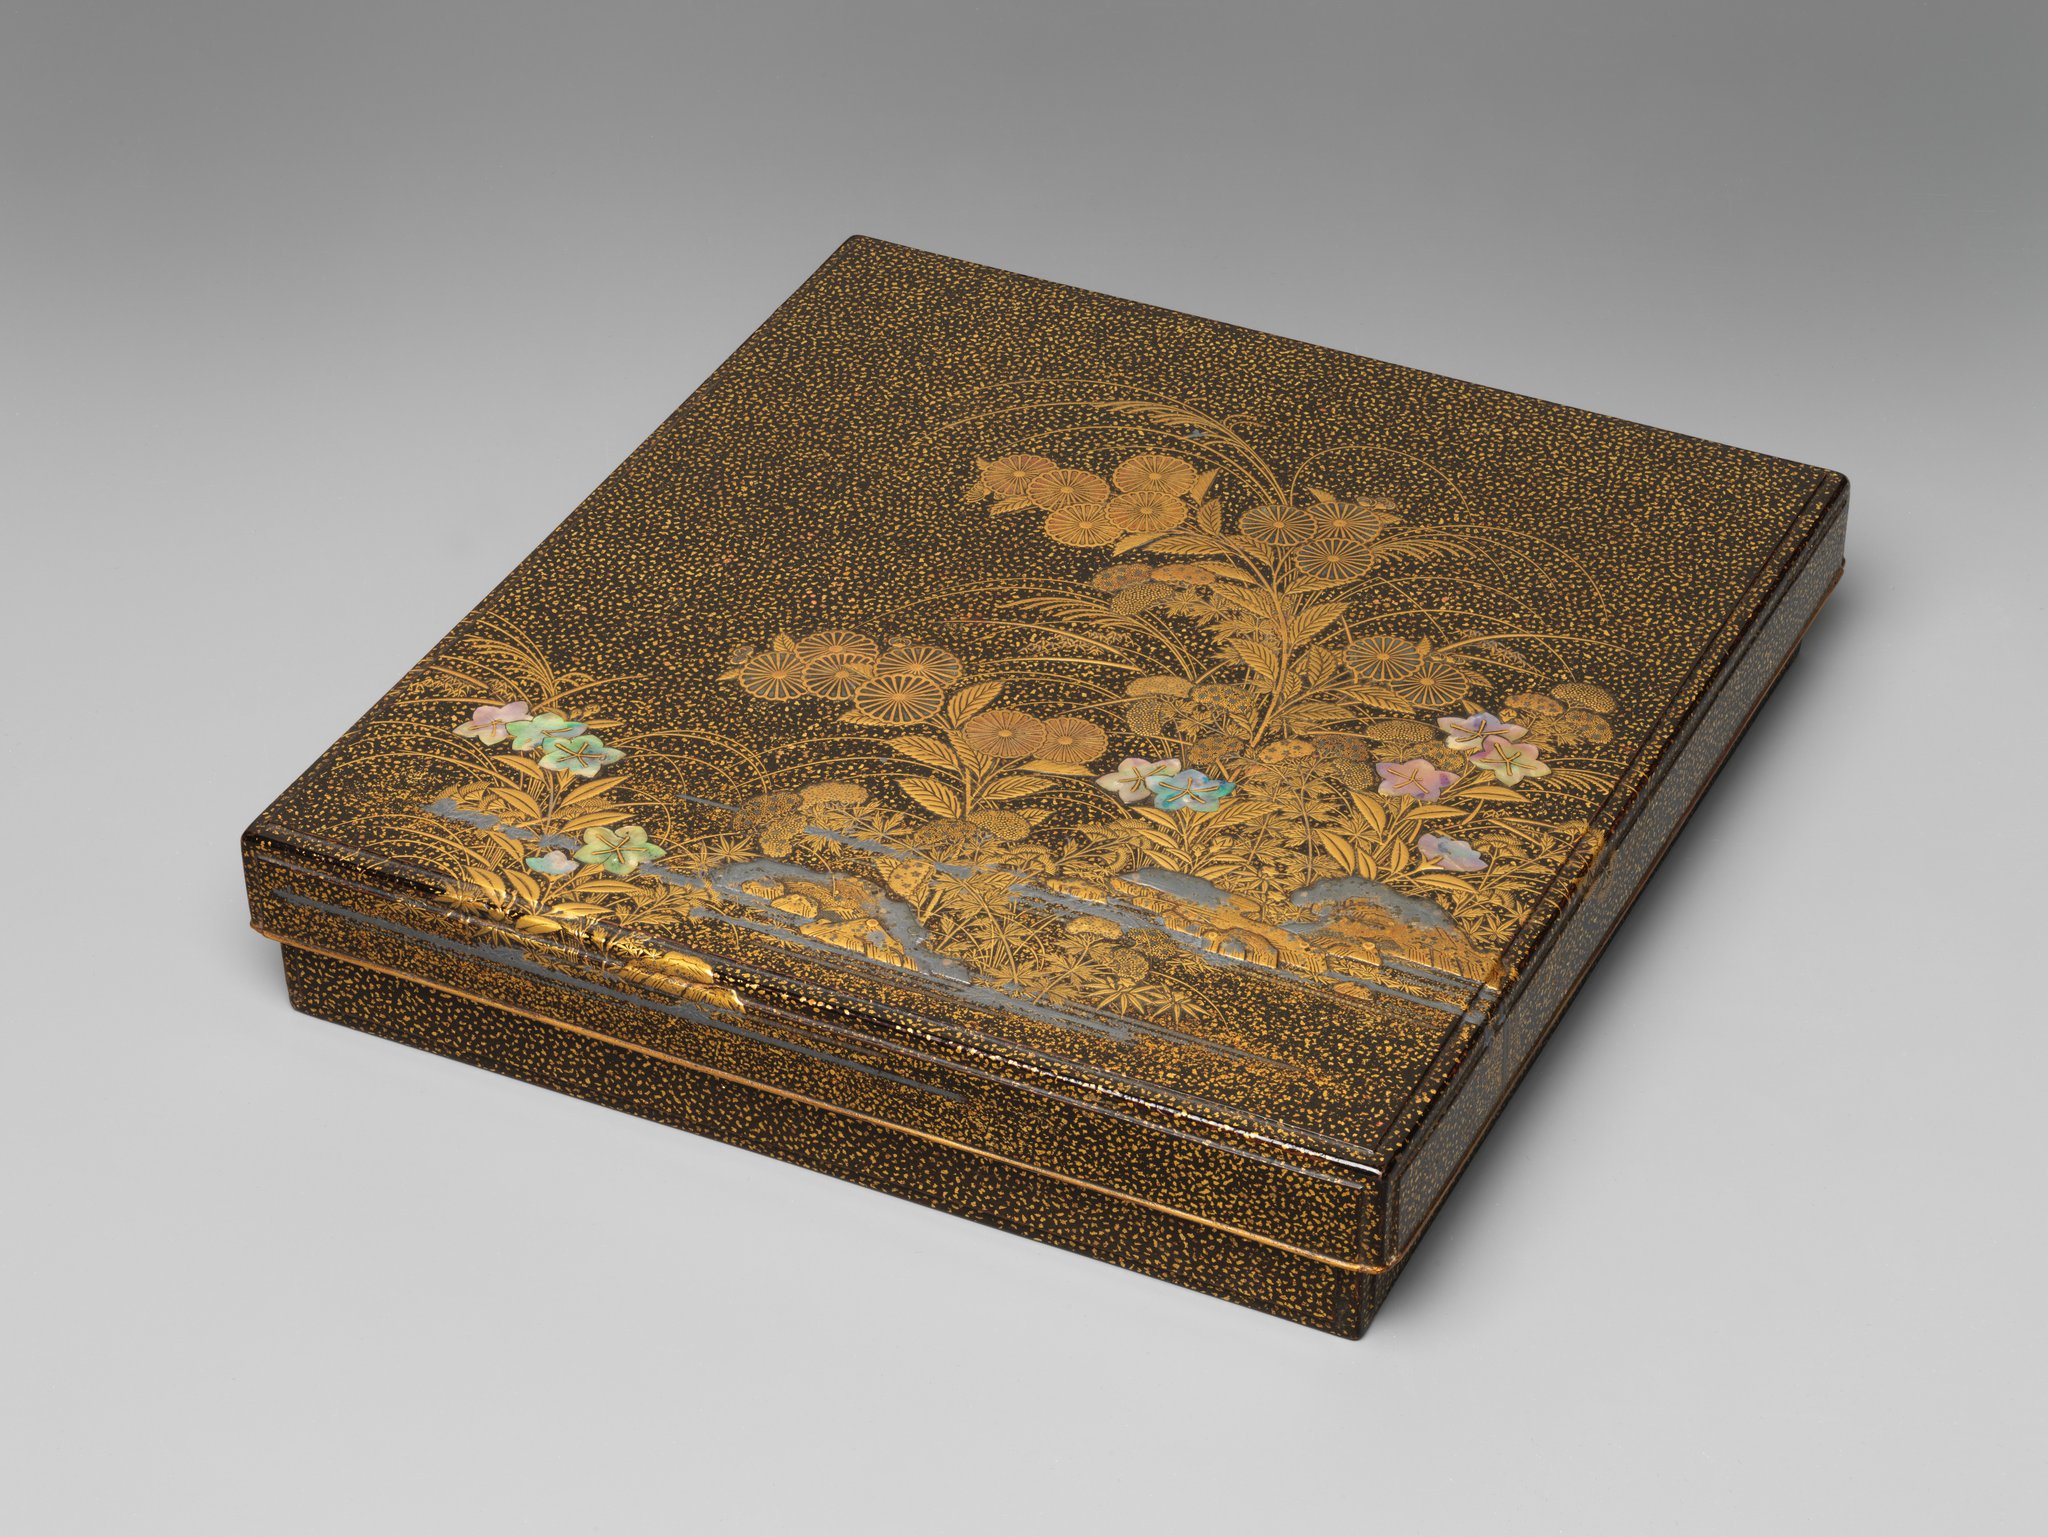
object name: writing box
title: Writing box (suzuribako) with chrysanthemums and autumn grasses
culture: japanese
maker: igarashi dōho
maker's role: artist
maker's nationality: japanese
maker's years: 1578-1678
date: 1651-1700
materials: foil, gold, mother of pearl, silver, wood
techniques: cutting, hiramakie, inlay, lacquer, maki-e